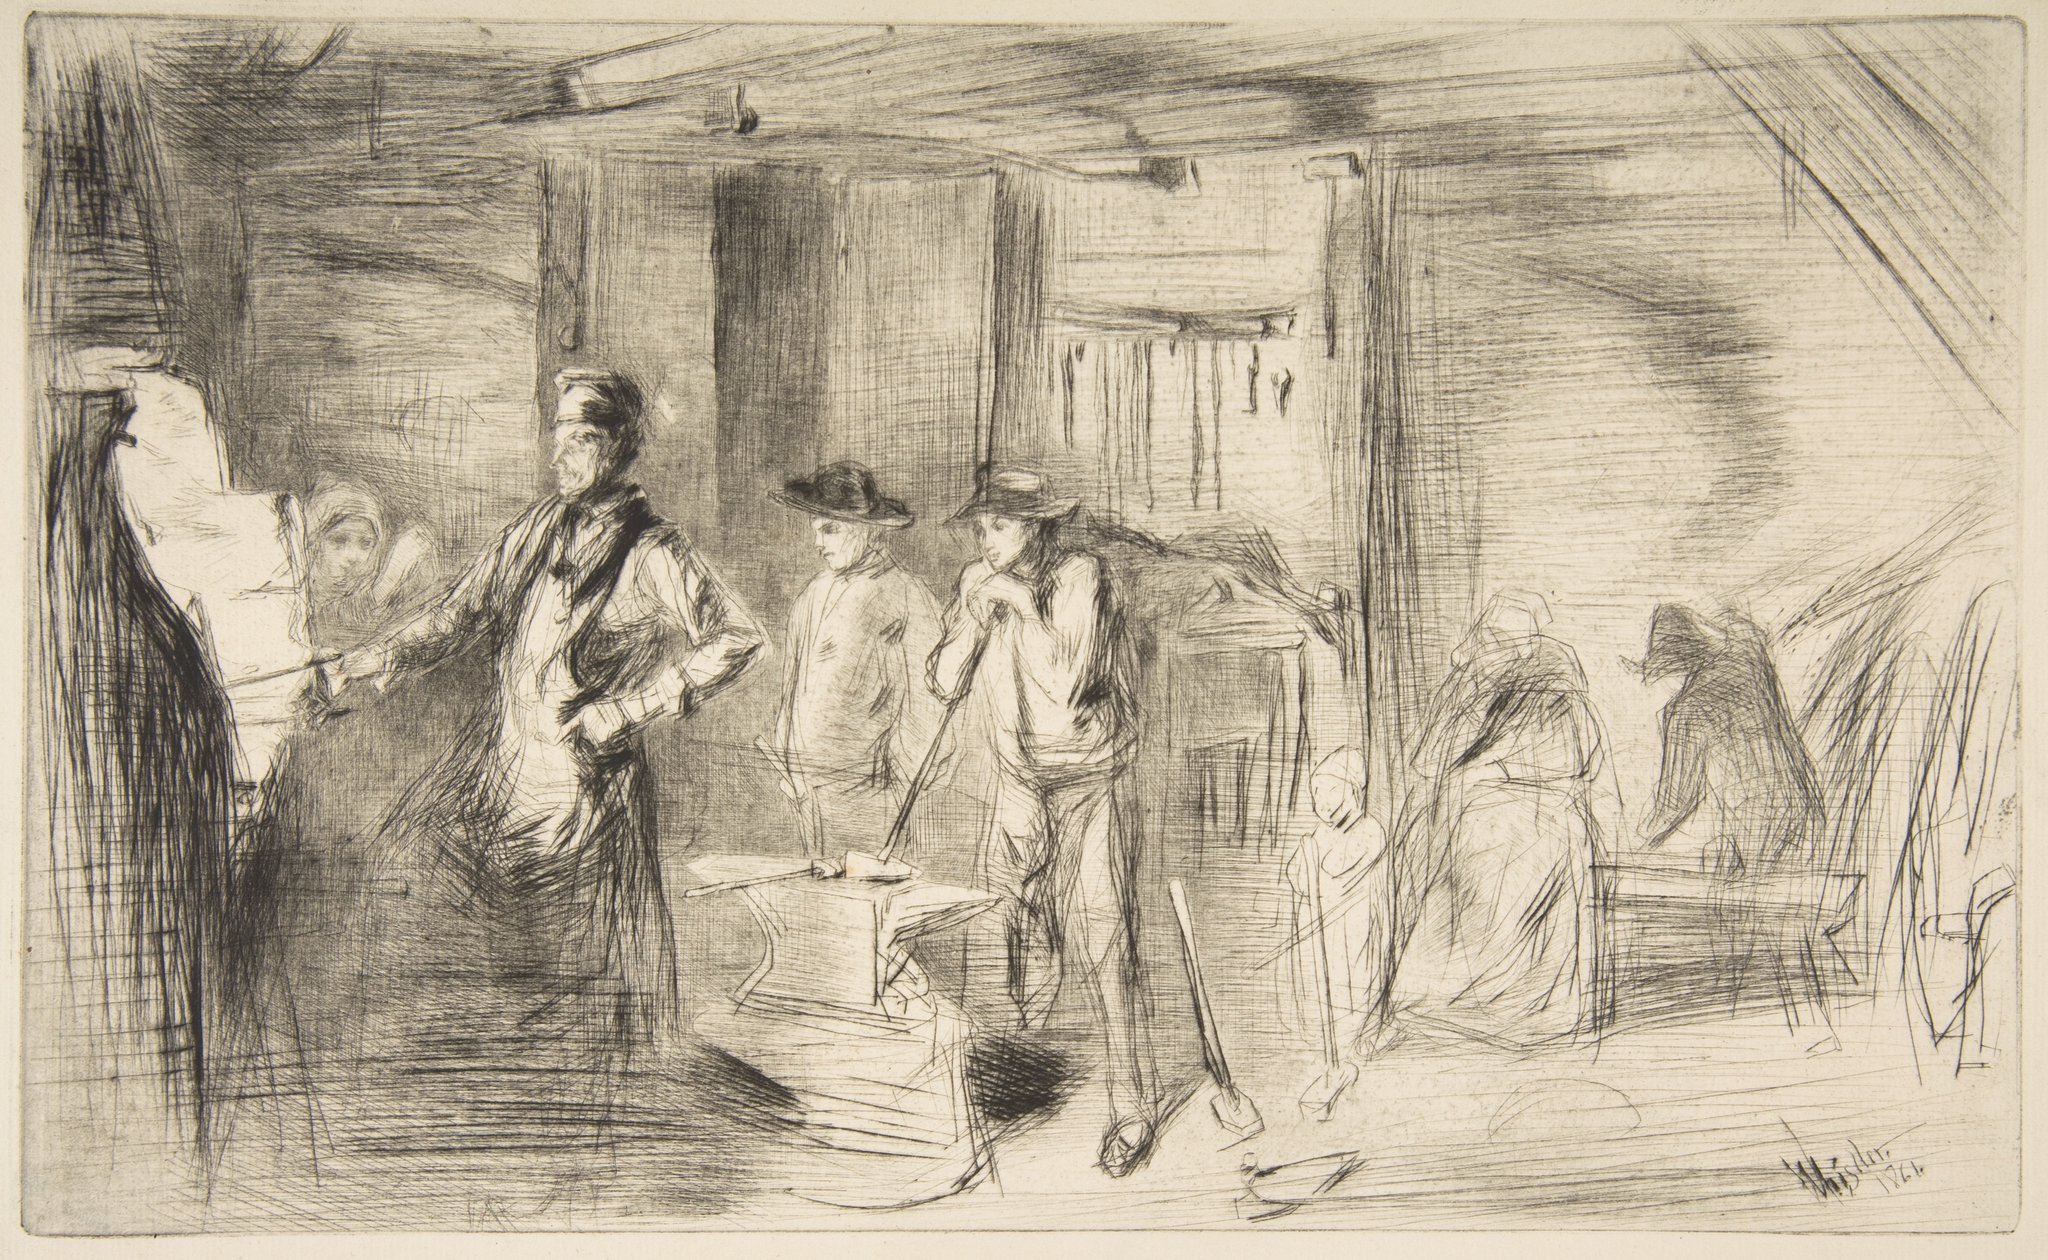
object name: print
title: The Forge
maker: james mcneill whistler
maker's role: artist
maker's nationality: american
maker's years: 1834-1903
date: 1861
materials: ink, paper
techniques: drypoint, printing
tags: hats,men